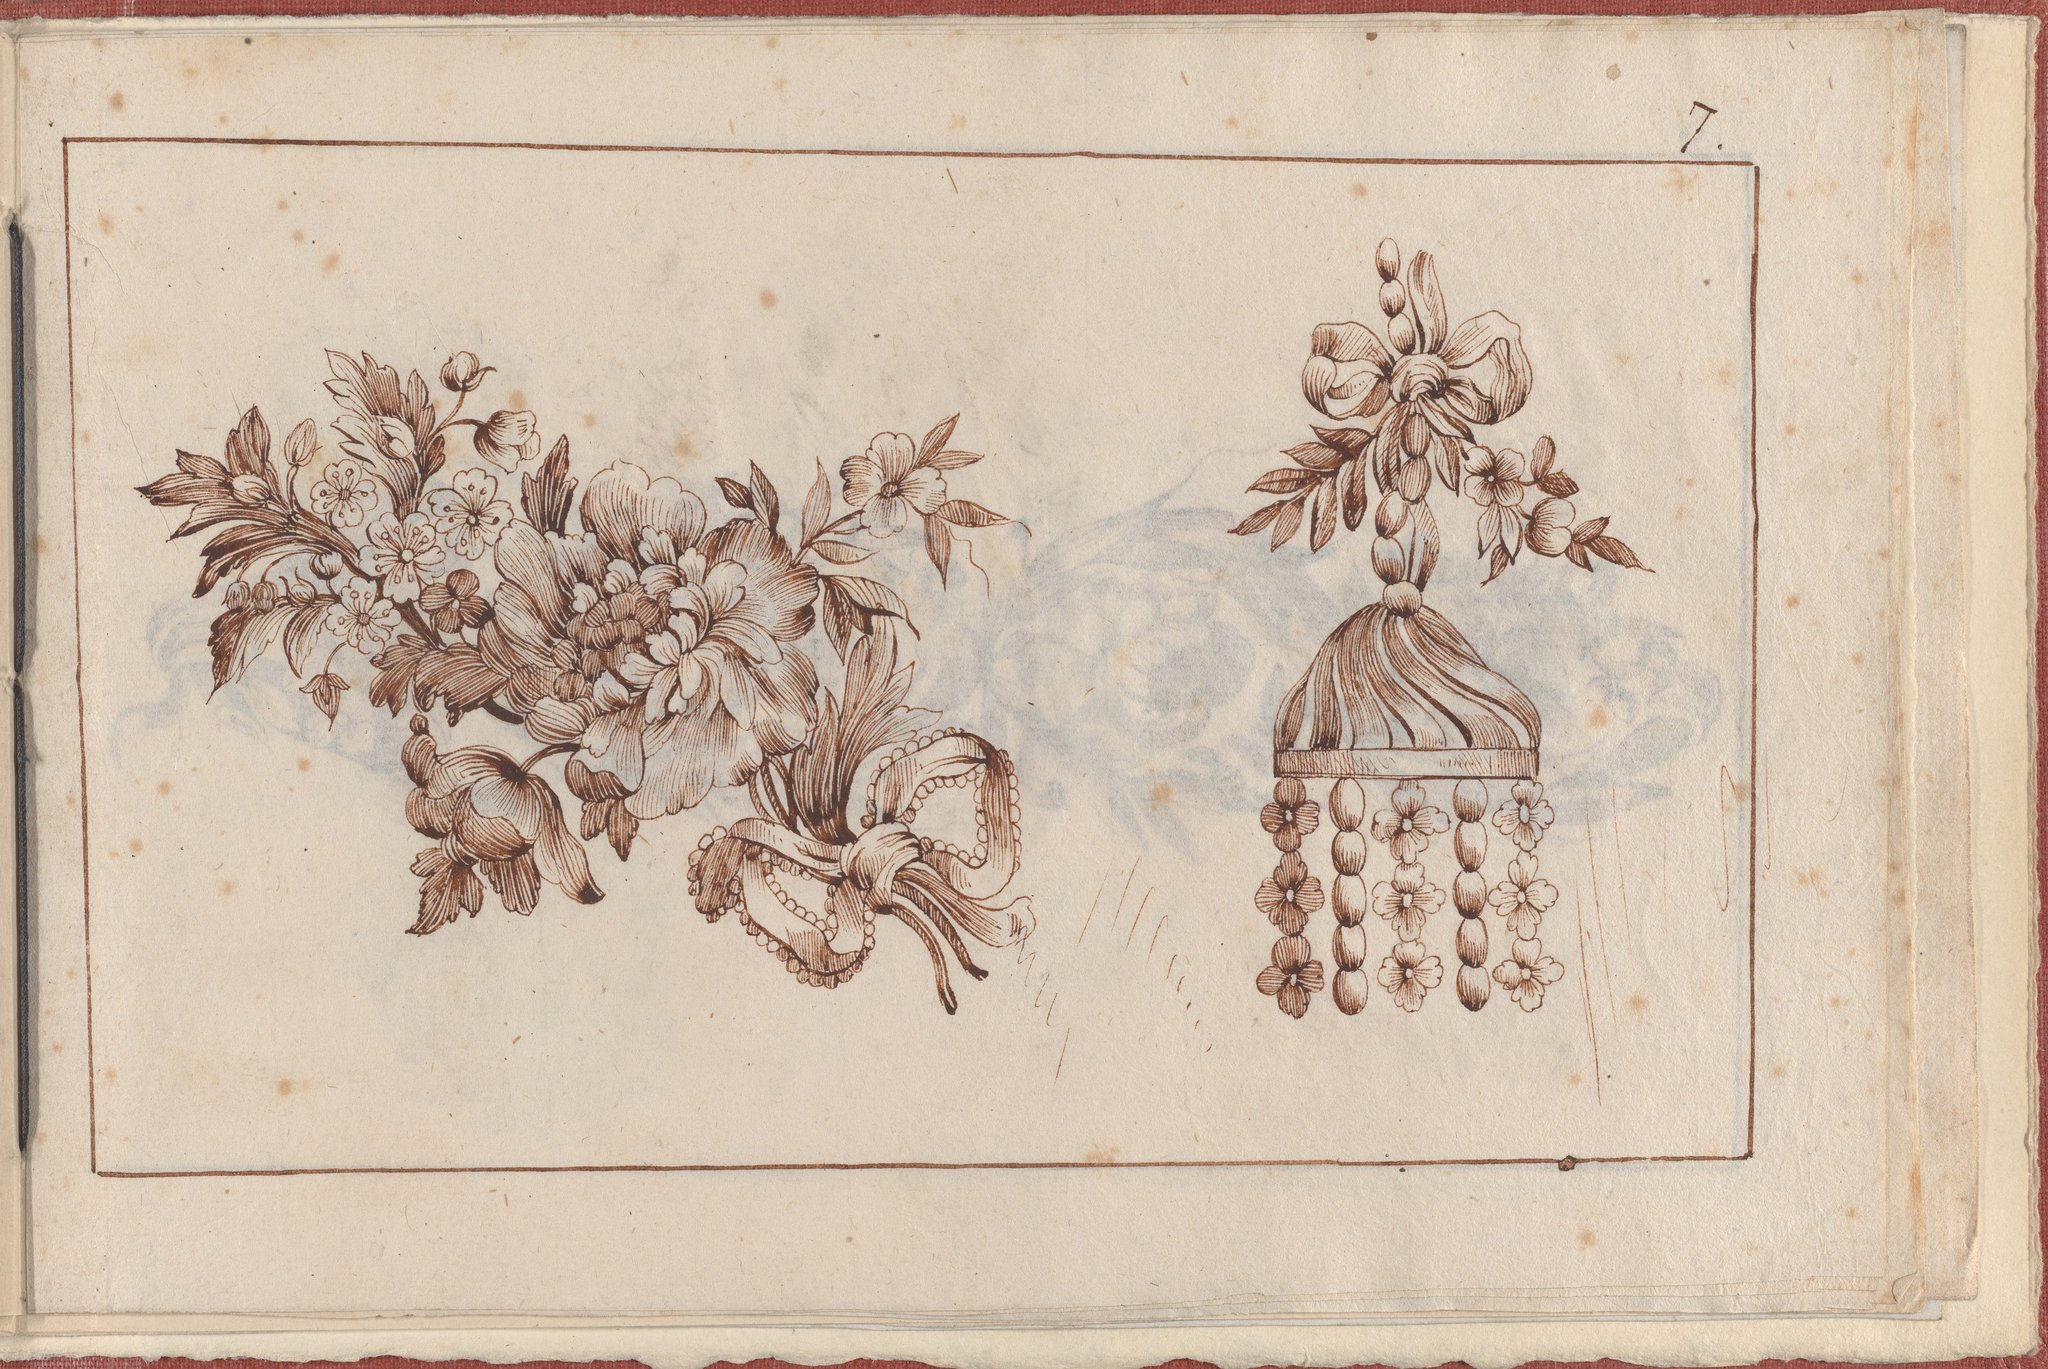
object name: album print ornament architecture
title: Joaillerie: Album of Jewelry Designs, Page 7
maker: anonymous, french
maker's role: artist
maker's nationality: french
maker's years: 1400-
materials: ink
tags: jewelry